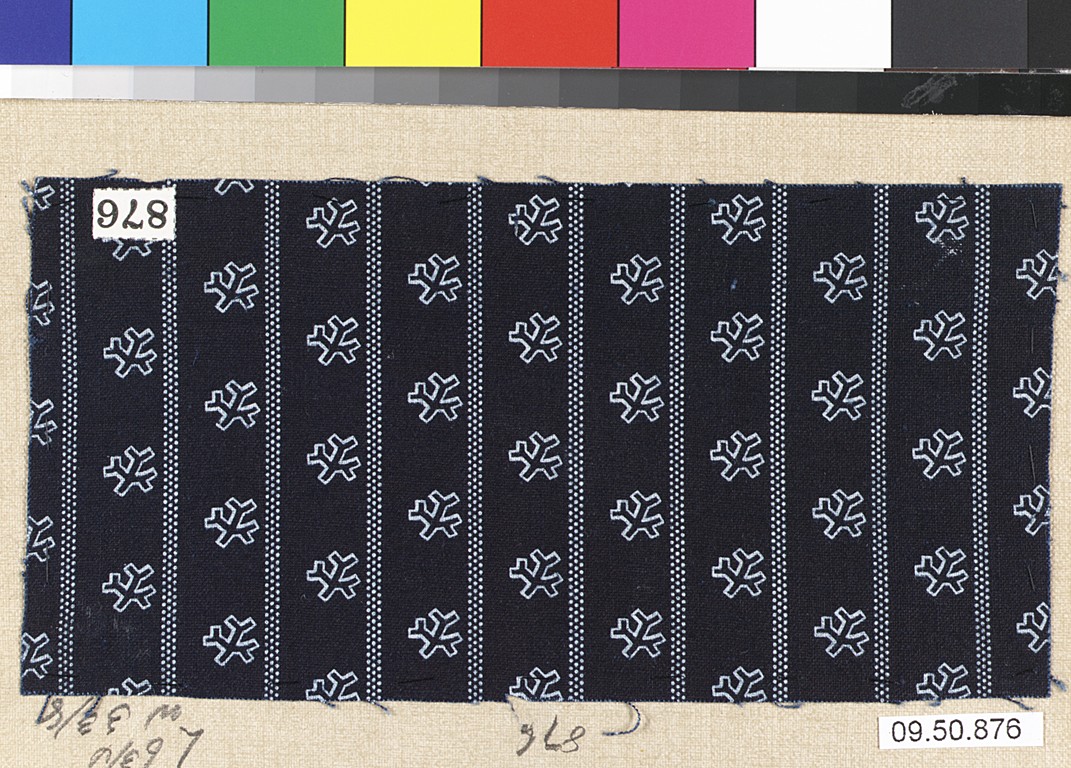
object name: piece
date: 1801-1900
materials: cotton